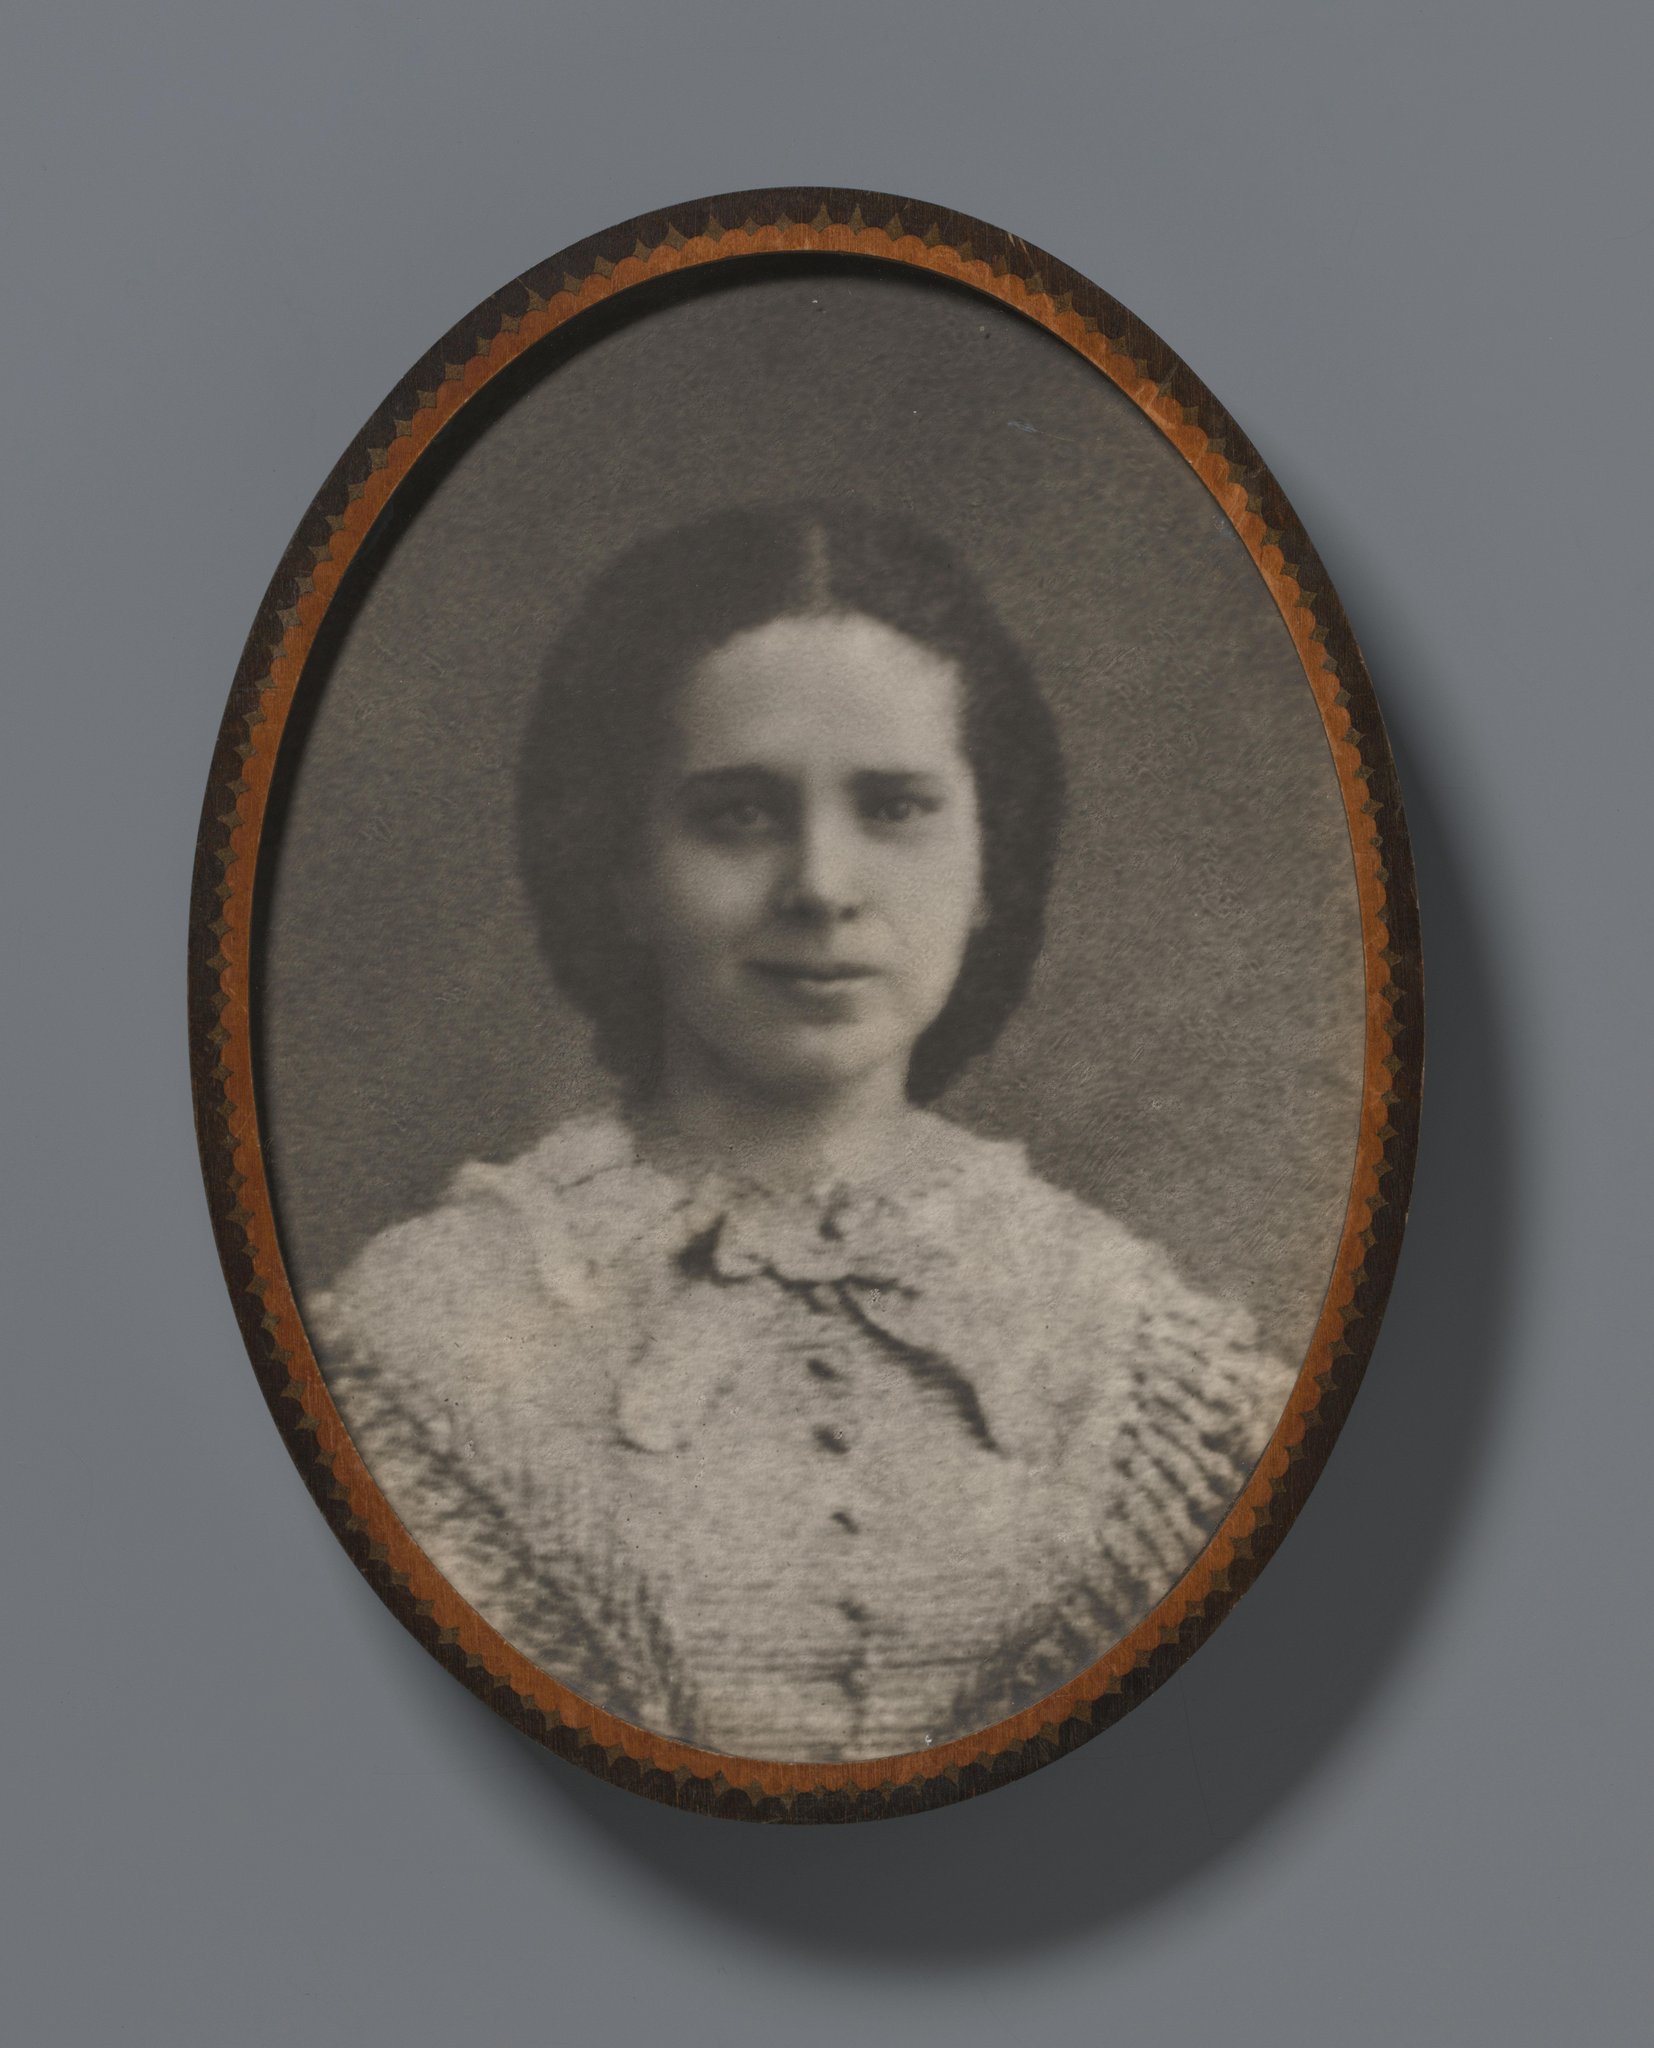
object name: frame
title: Portret van Carolina Frederika Holle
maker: Anonymous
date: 1880-1900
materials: paper, cardboard, glass, metal, wood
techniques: gelatin silver print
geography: java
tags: amsterdam, carolina frederika van den berg-holle, historical persons - bb - woman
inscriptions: inscription: ‘Carolina Frederika HOLLE/ (1840-1909), echtgenote/ van Mr Norbertus Petrus/ van den BERG’, inscription: ‘LIJSTENFABRIEK/ H. GONKEL Jz. & ZOON VERGULDERS/ KERKSTR. 217 AMSTERDAM/ TEL. 48381/ OPGER. 1884.’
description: Portret van Carolina Frederika Holle in lijst, mogelijk een vergroting naar een vroegere foto van Woodbury & Page.